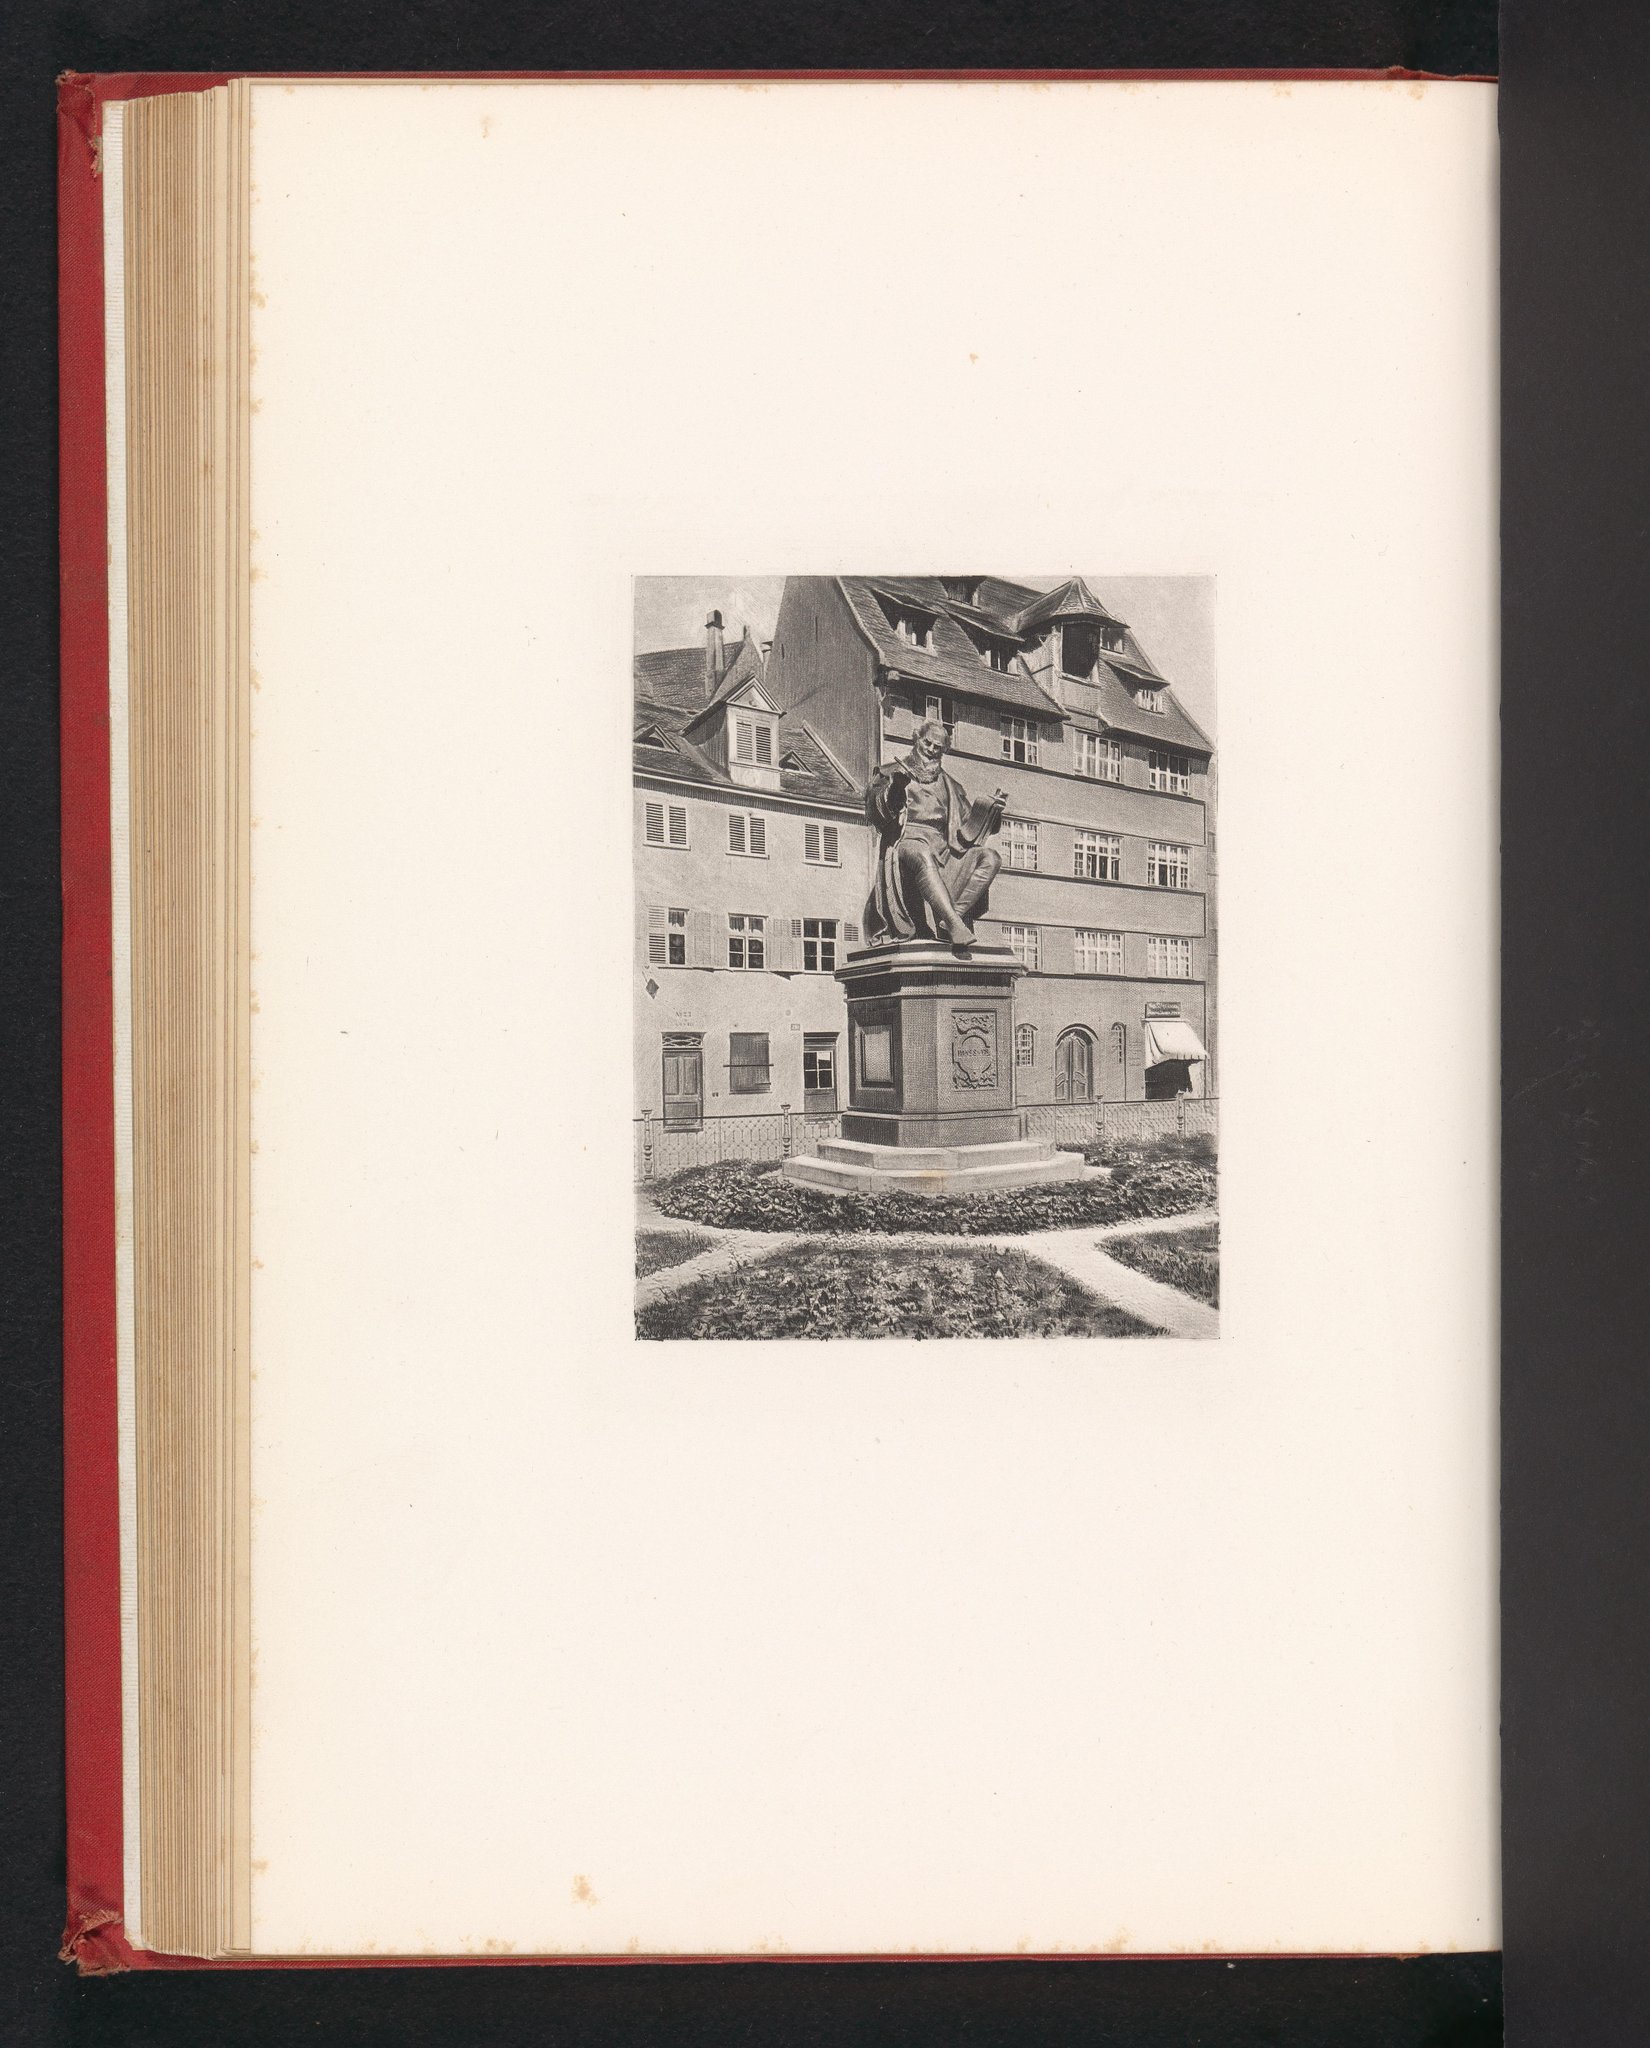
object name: photomechanical print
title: Standbeeld van Hans Sachs in Neurenberg door Johann Konrad Krausser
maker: Anonymous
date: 1878-1888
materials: paper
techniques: photoaquatint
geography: nuremberg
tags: hans sachs, monument, statue